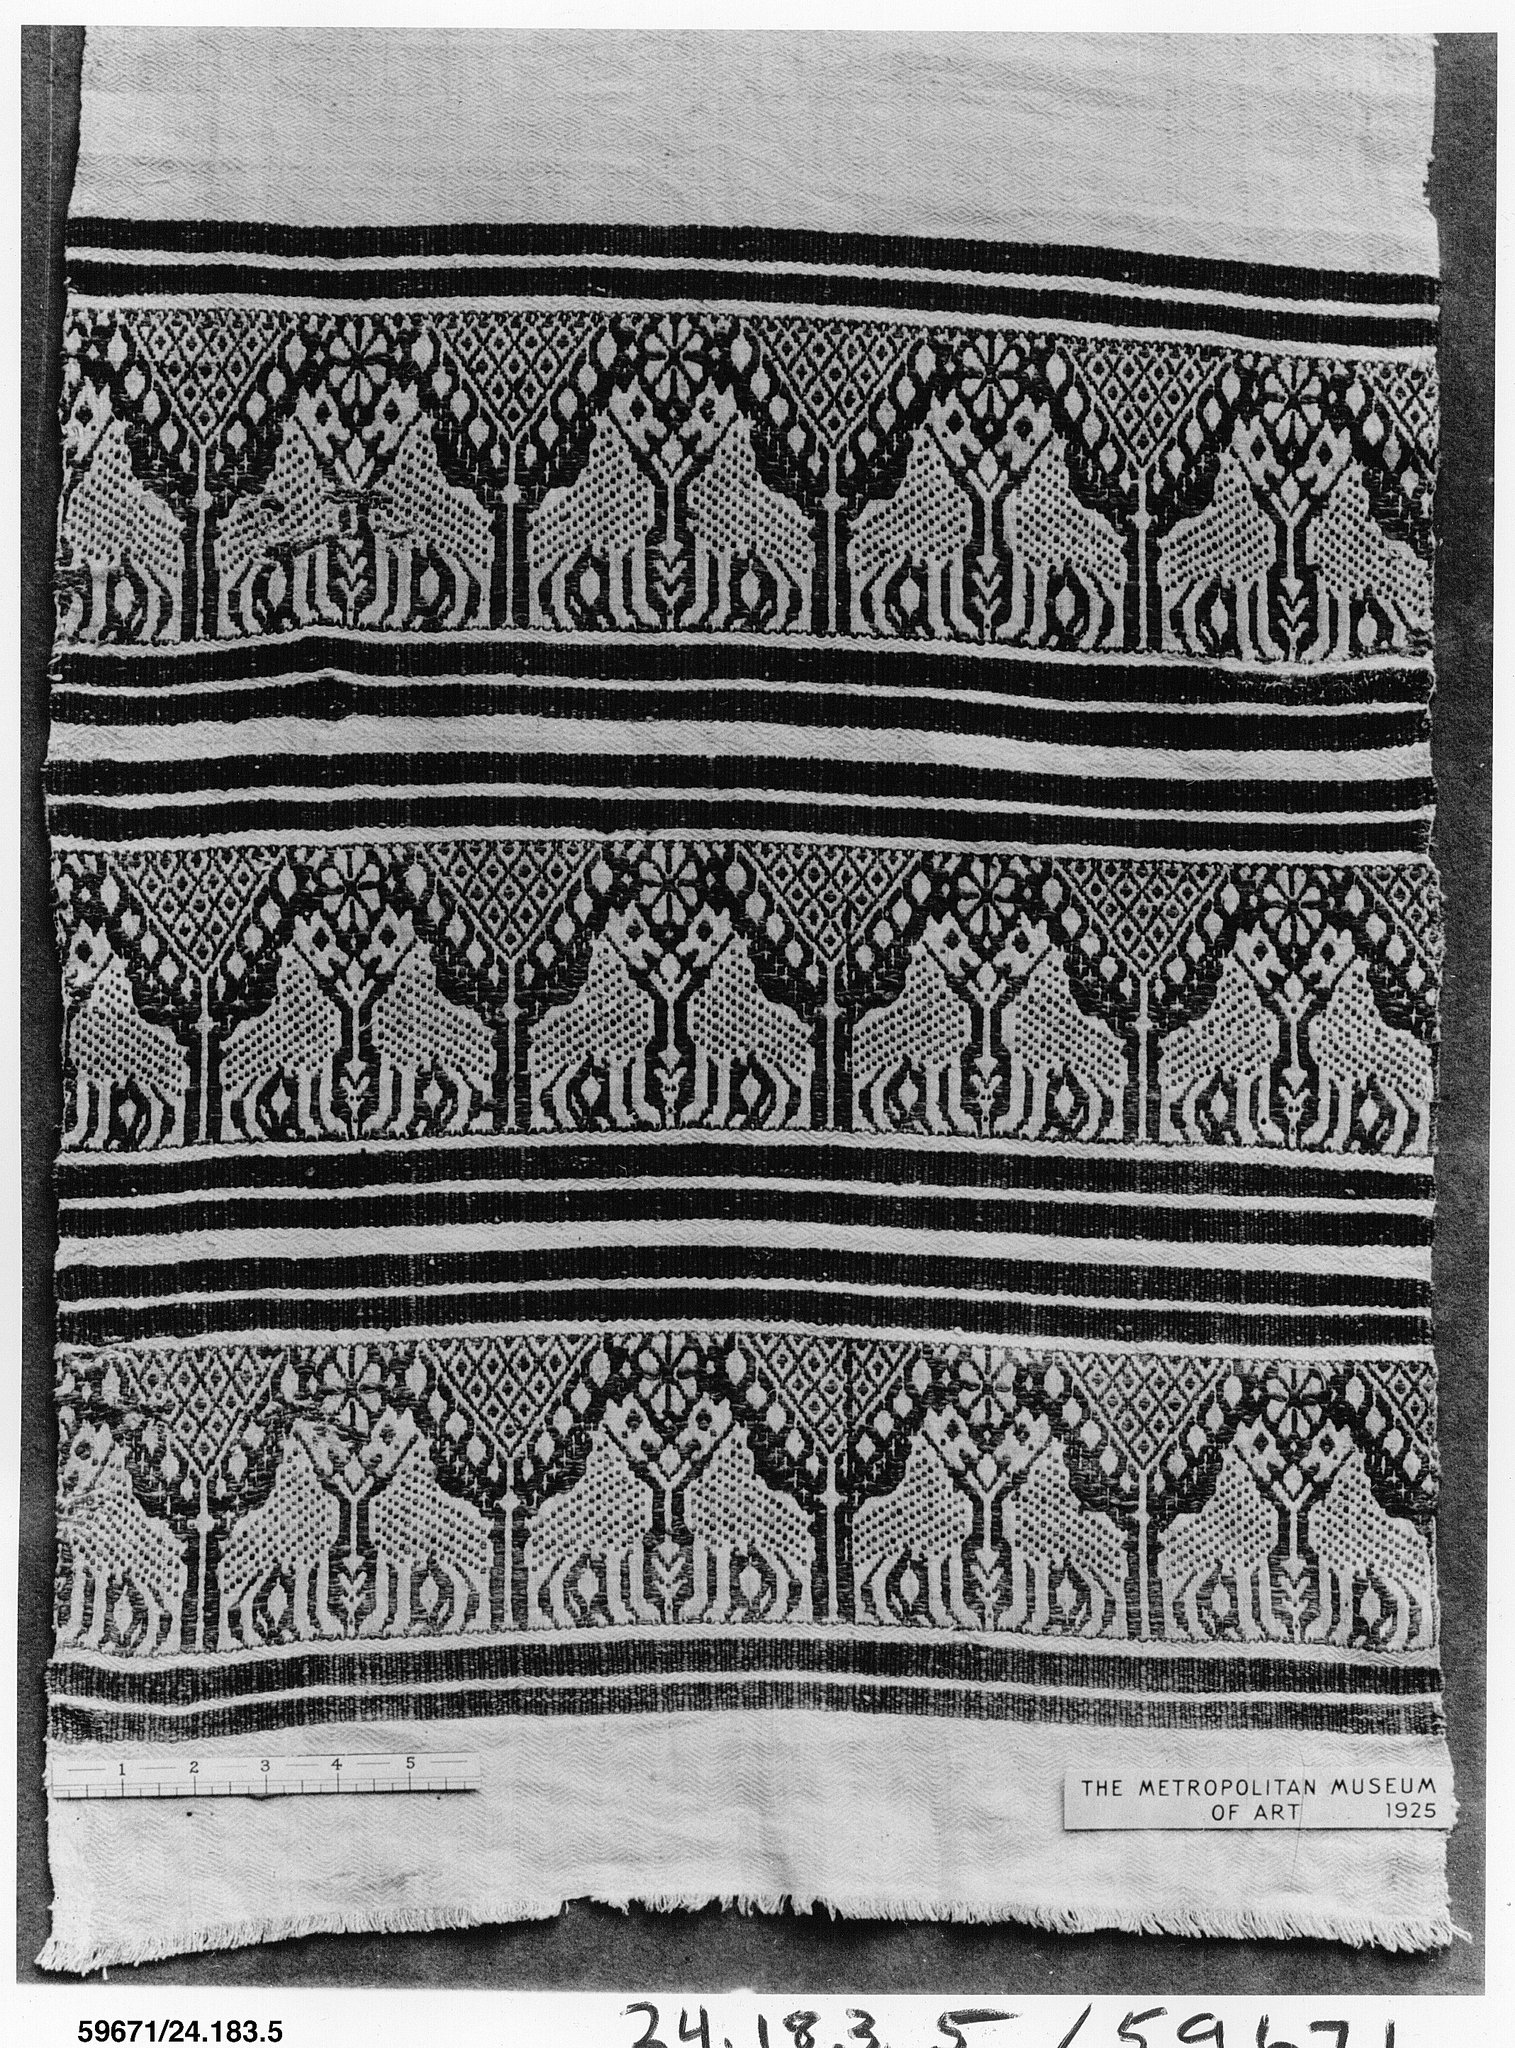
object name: towel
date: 1801-1900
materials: linen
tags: animals